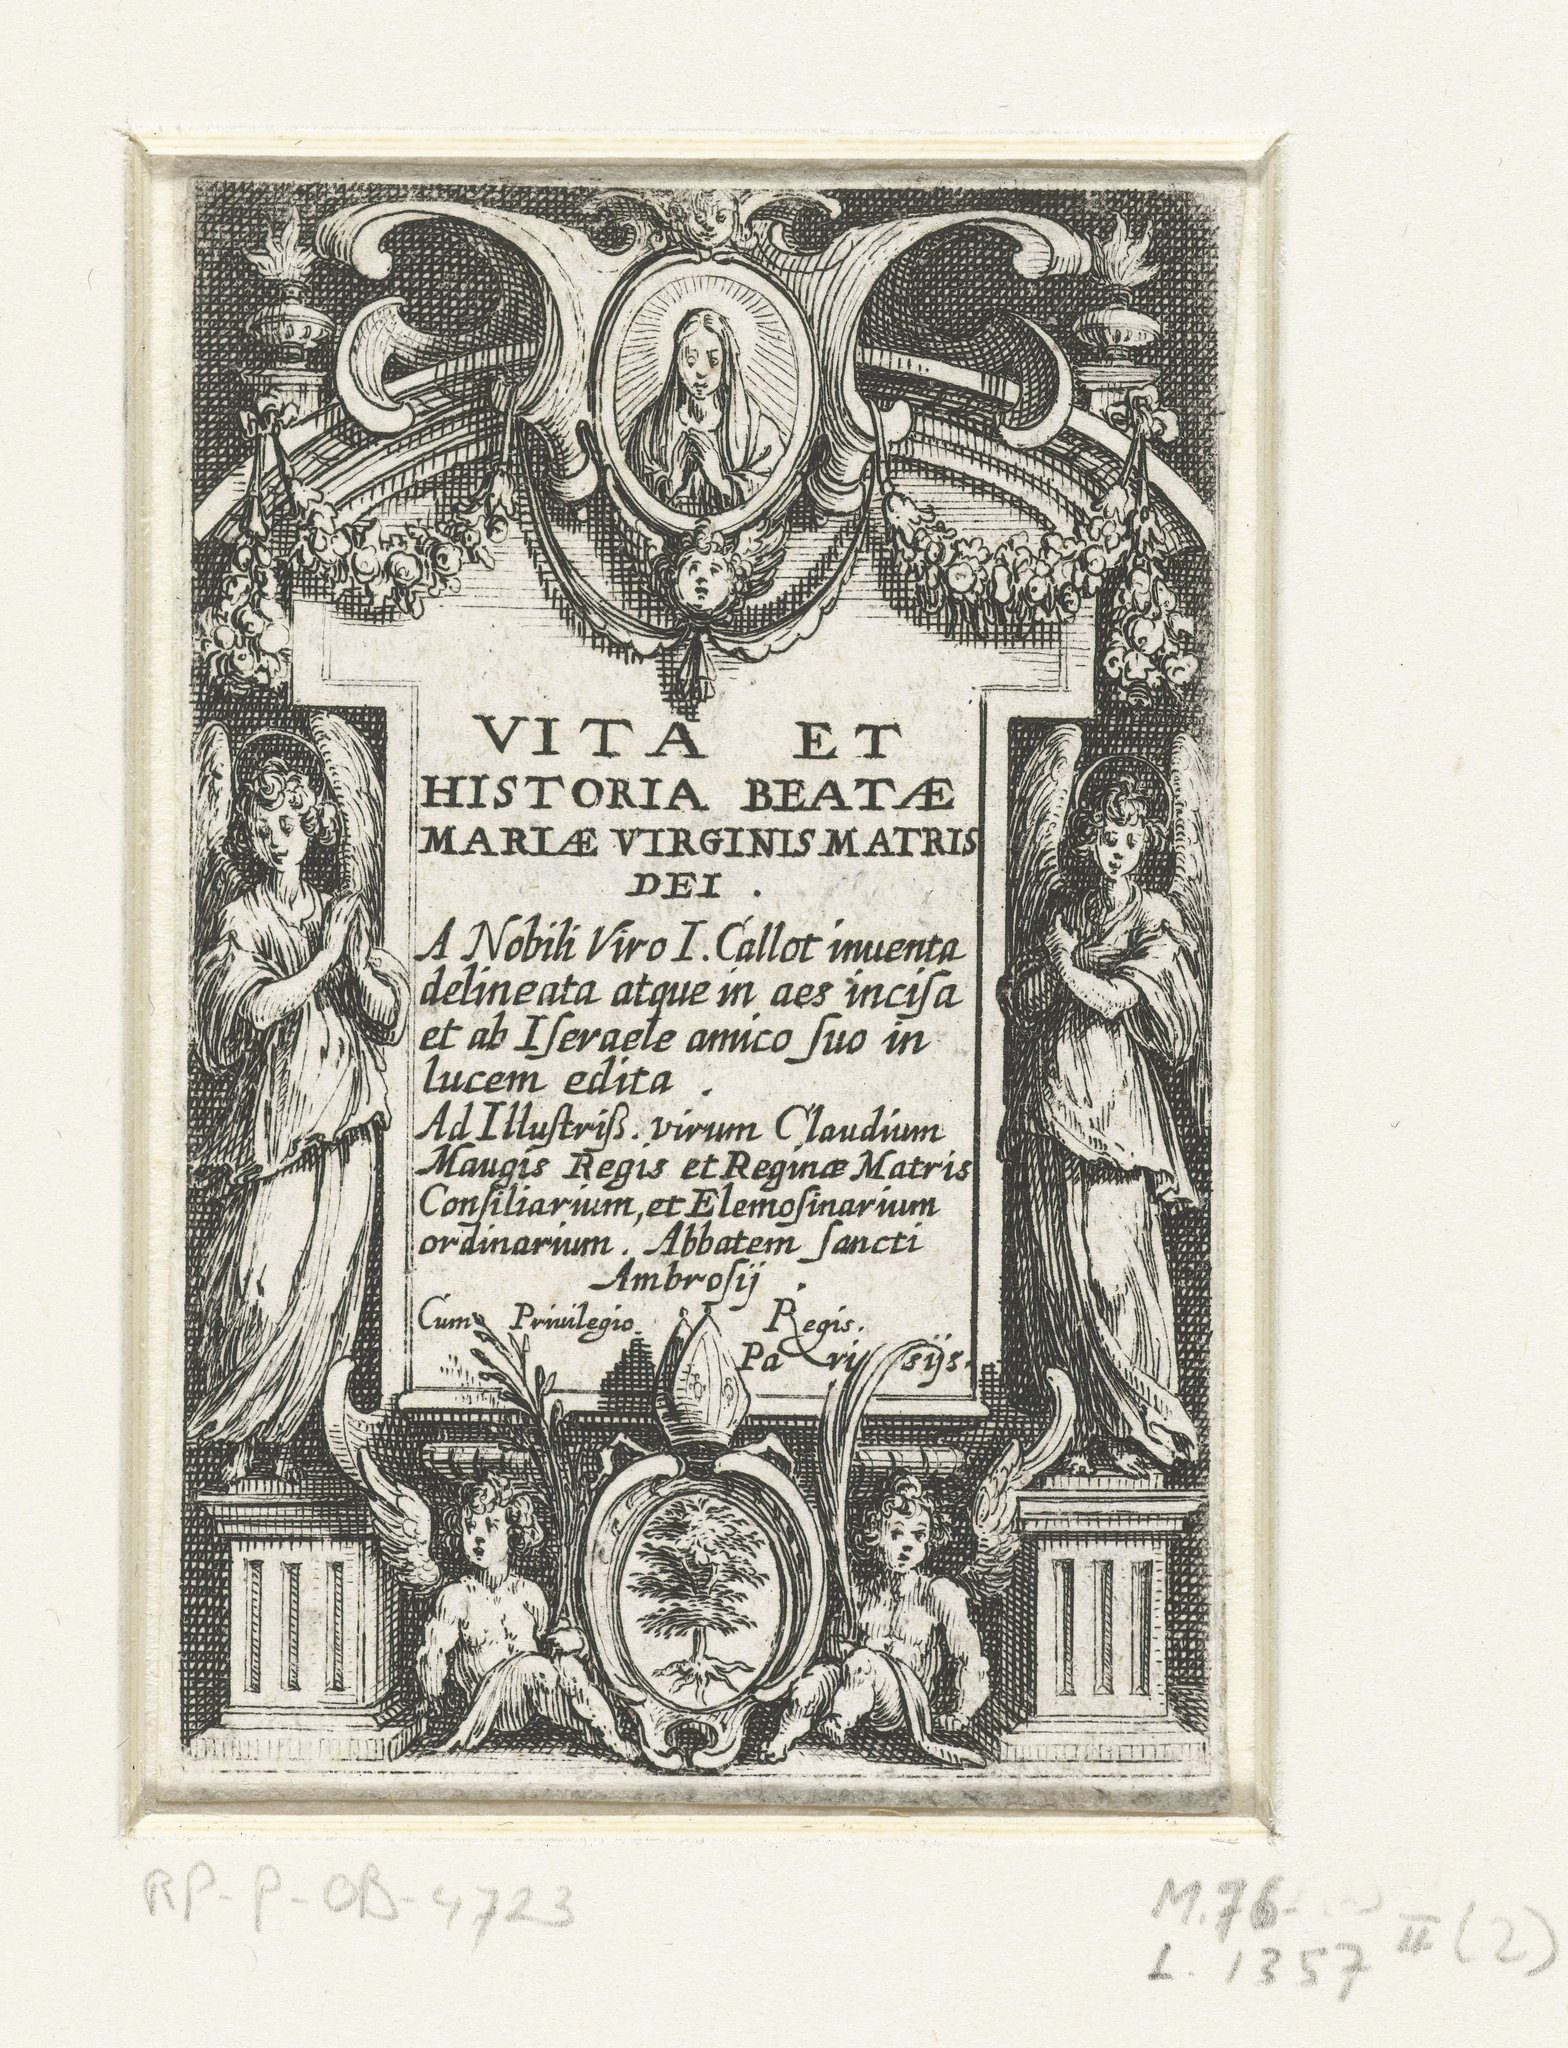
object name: print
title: Vita et historia beatae Mariae virginis matris dei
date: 1633-1634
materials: paper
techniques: etching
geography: nancy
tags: the virgin mary, title-page, angels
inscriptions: collector's mark: Lugt 240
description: Latijnse tekst op een tablet aan weerszijden waarvan engelen op sokkels staan. Boven de tekst een medaillon met portret van Maria. Eronder een wapenschild en twee putti. Deze prent is het titelblad voor een reeks van dertien prenten met scènes uit het leven van Maria.